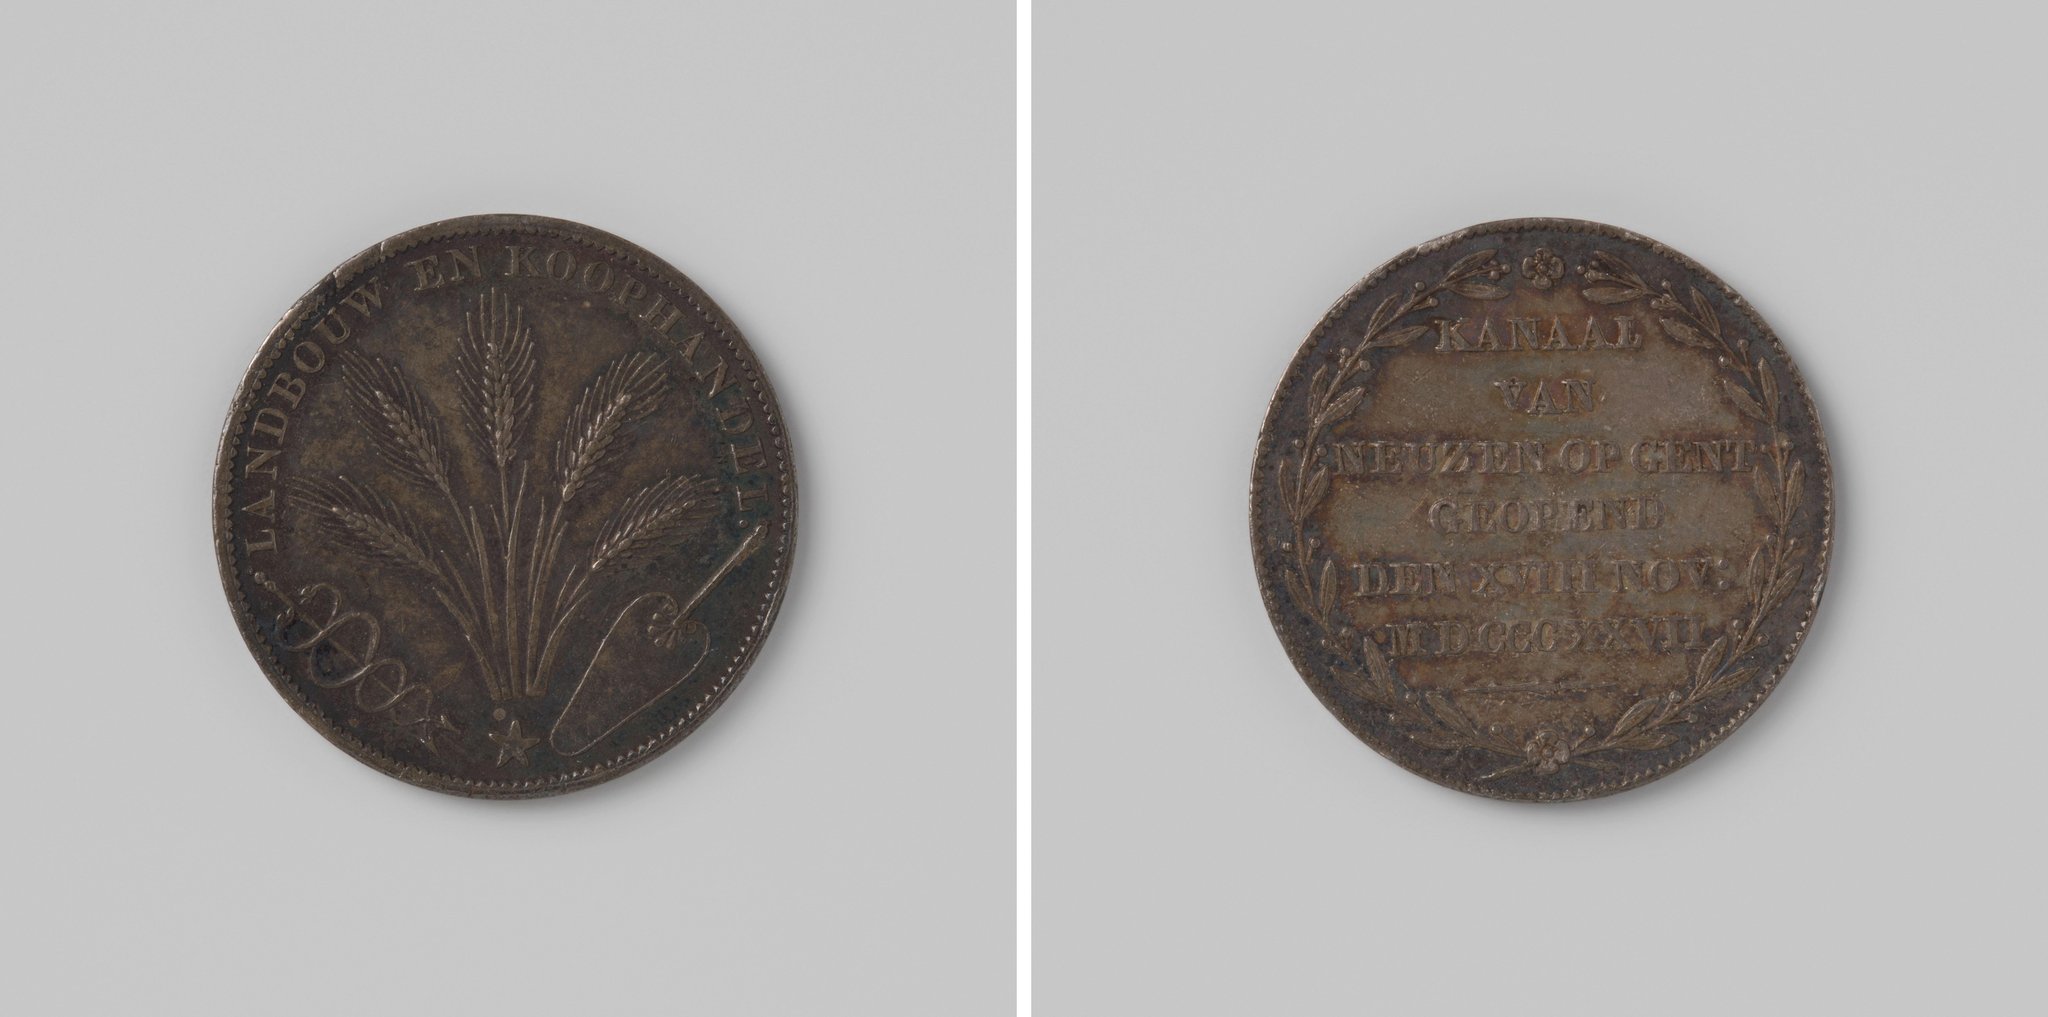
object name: strooipenning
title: Opening van het Kanaal van Terneuzen naar Gent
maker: joseph pierre braemt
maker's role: print maker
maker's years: 1796-1864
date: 1827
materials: silver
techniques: striking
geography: brussels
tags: william i of the netherlands, ghent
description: Zilveren penning. Voorzijde: vijf rijpe korenaren, scheepsroer en Mercuriusstaf binnen omschrift. Keerzijde: opschrift binnen krans van olijftakken